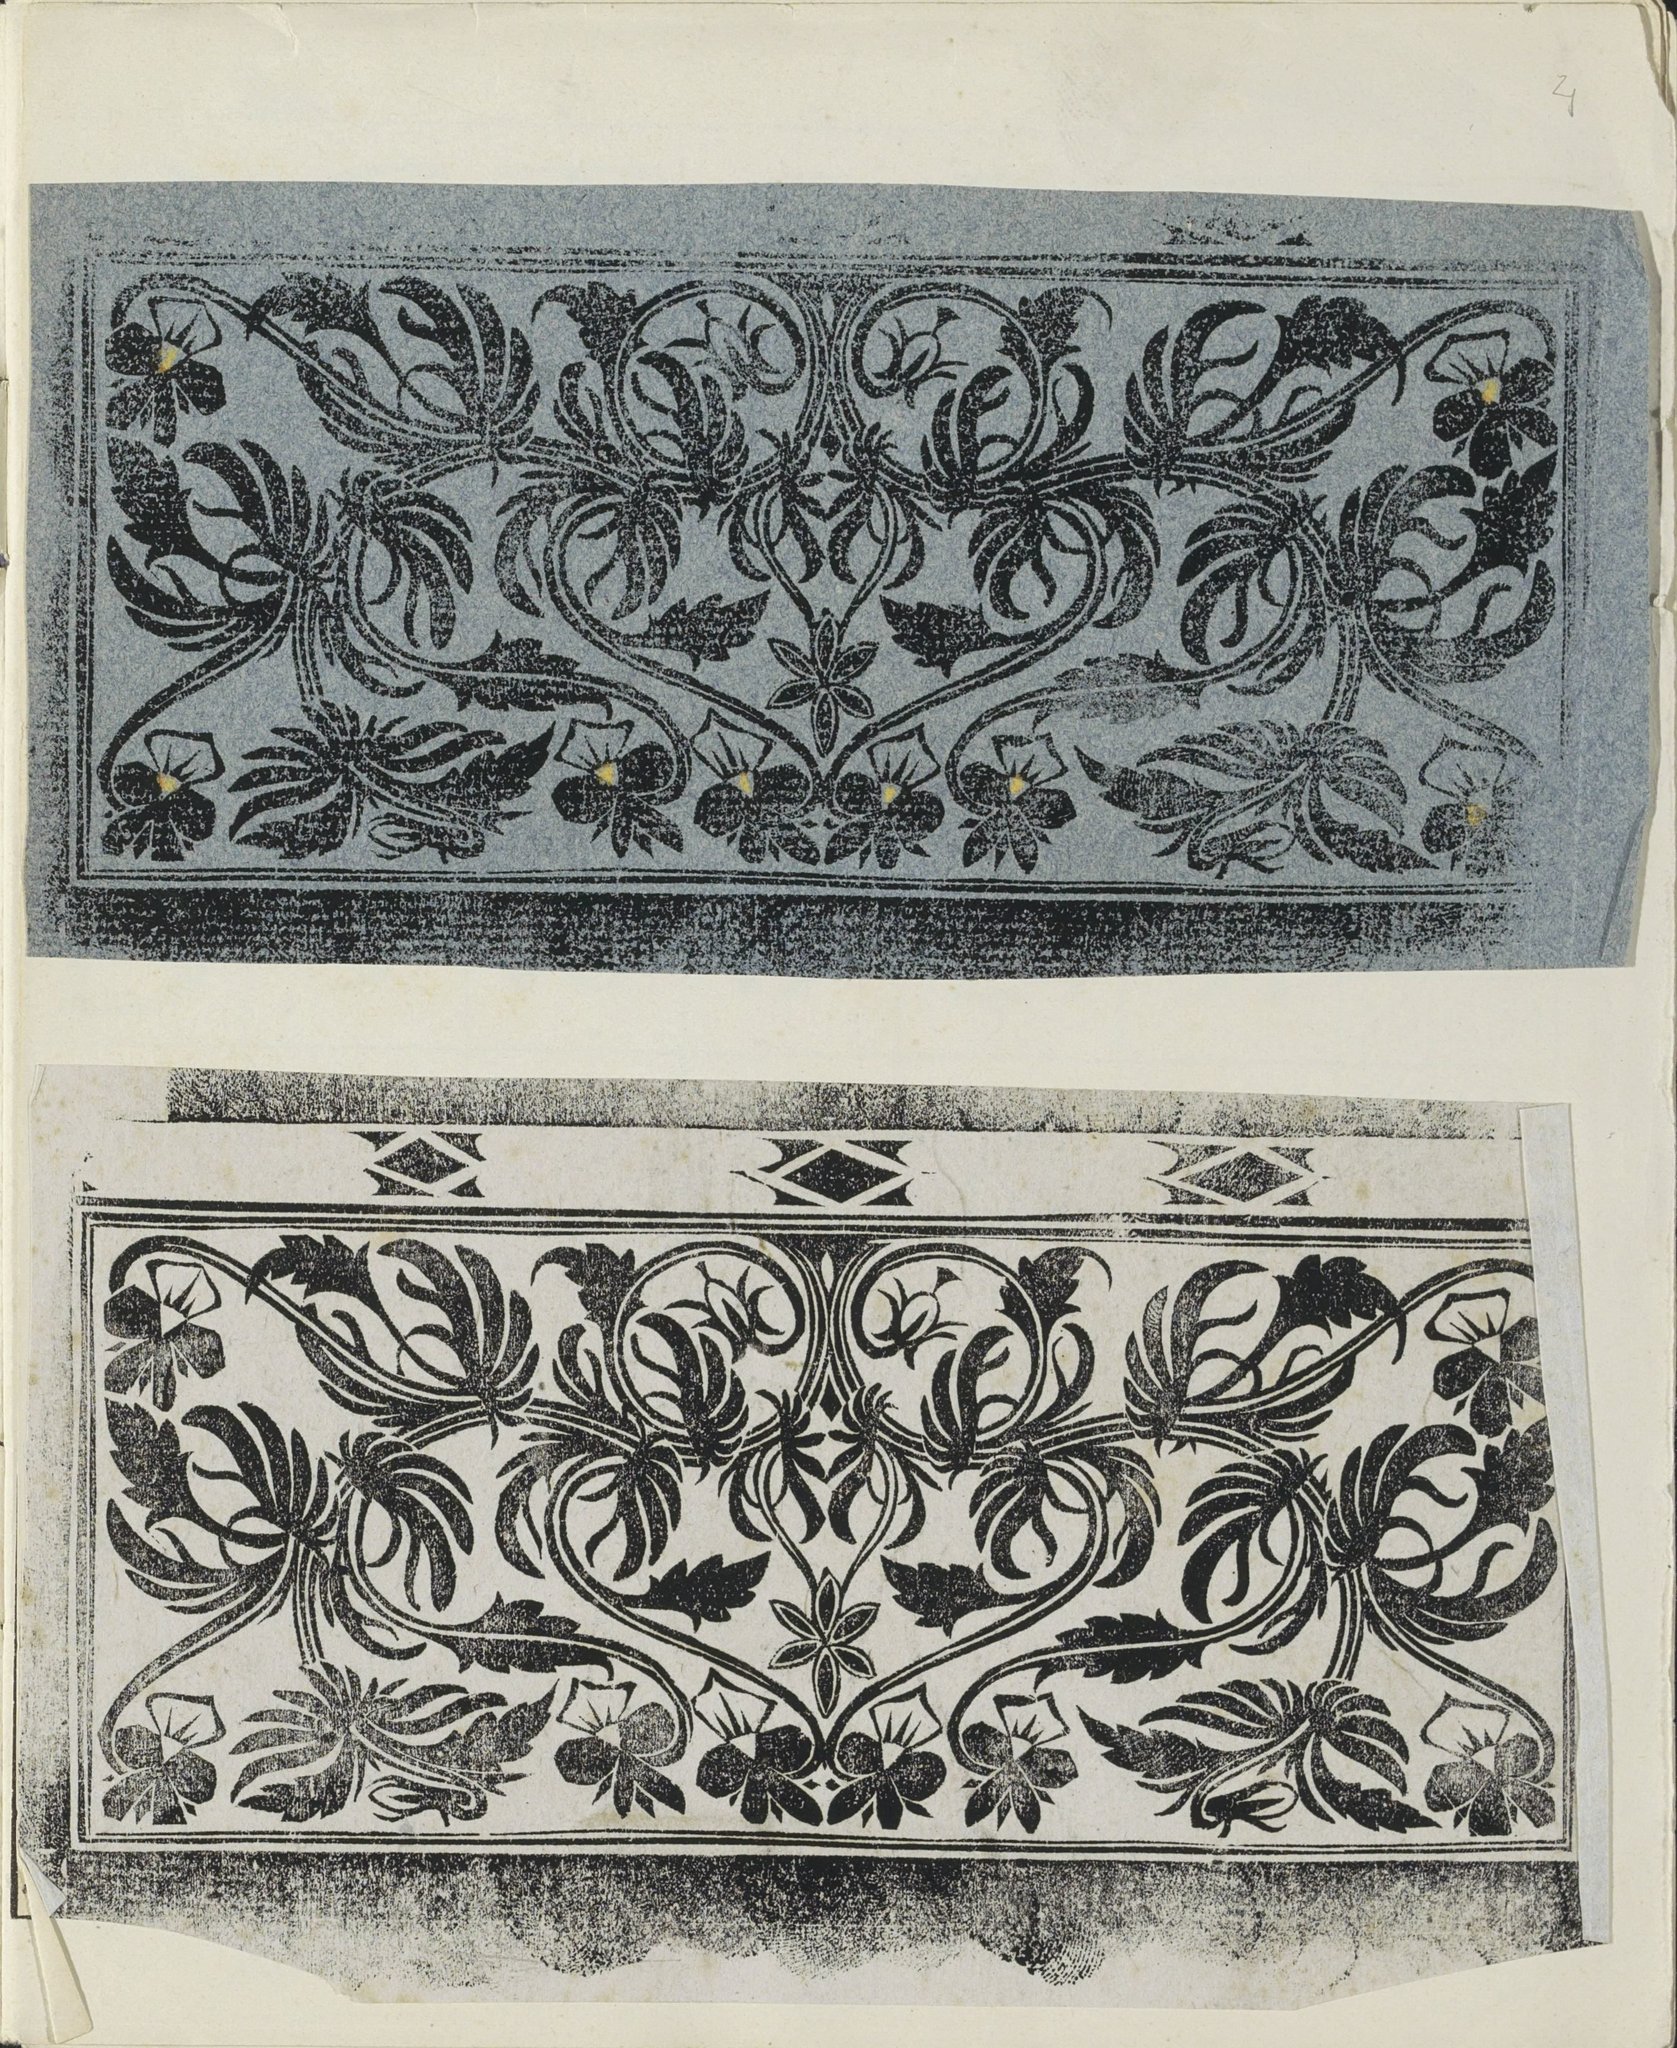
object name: album leaf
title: Twee banden met florale ornamenten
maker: gerrit willem dijsselhof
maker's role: designer, draughtsman, print maker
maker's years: 1866-1924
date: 1876-1924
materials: paint, paper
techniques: brush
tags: flowers ~ ornament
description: Blad 4 recto uit een album met 17 bladen.